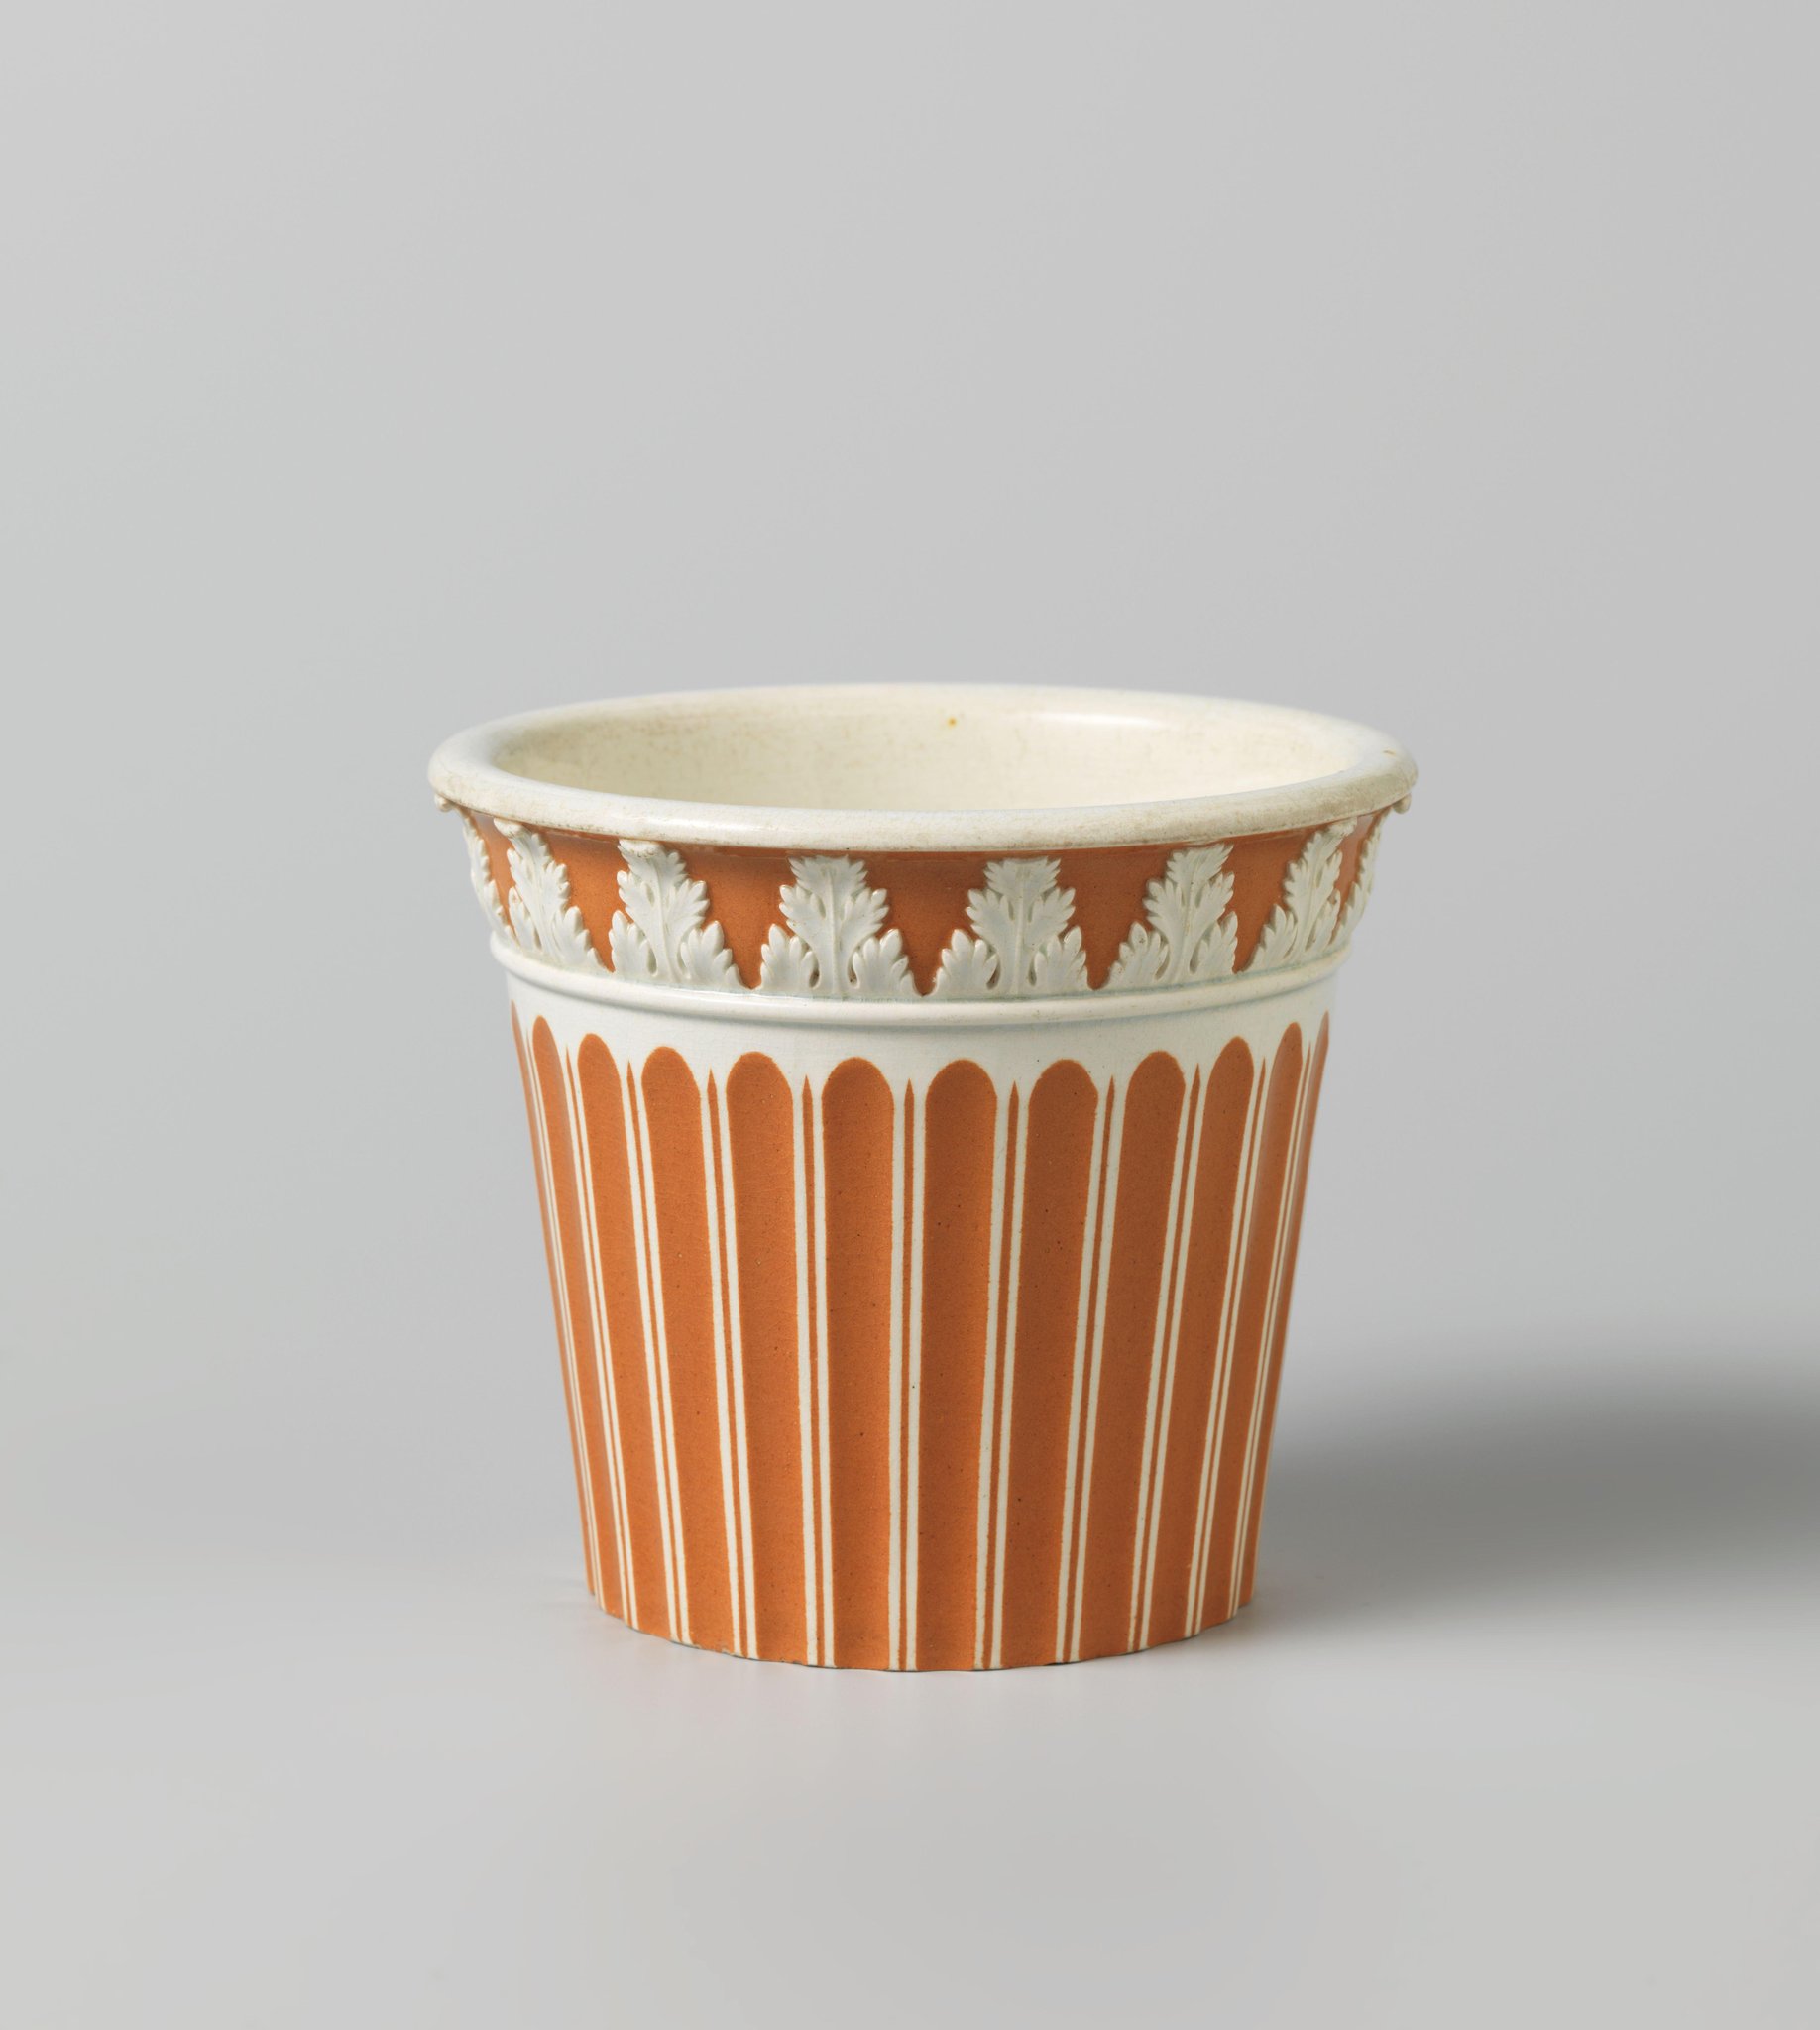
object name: pot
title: Bloempot van hardgebakken aardewerk, Wedgwood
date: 1790-1810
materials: earthenware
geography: england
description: Bloempot van hardgebakken aardewerk. De pot is in reliëf versierd met bruine en witte cannelures waarboven een rand witte acanthus bladeren. De pot is gemerkt. Bij de pot hoort een tweede bloempot met invnr. BK-NM-14086-B.